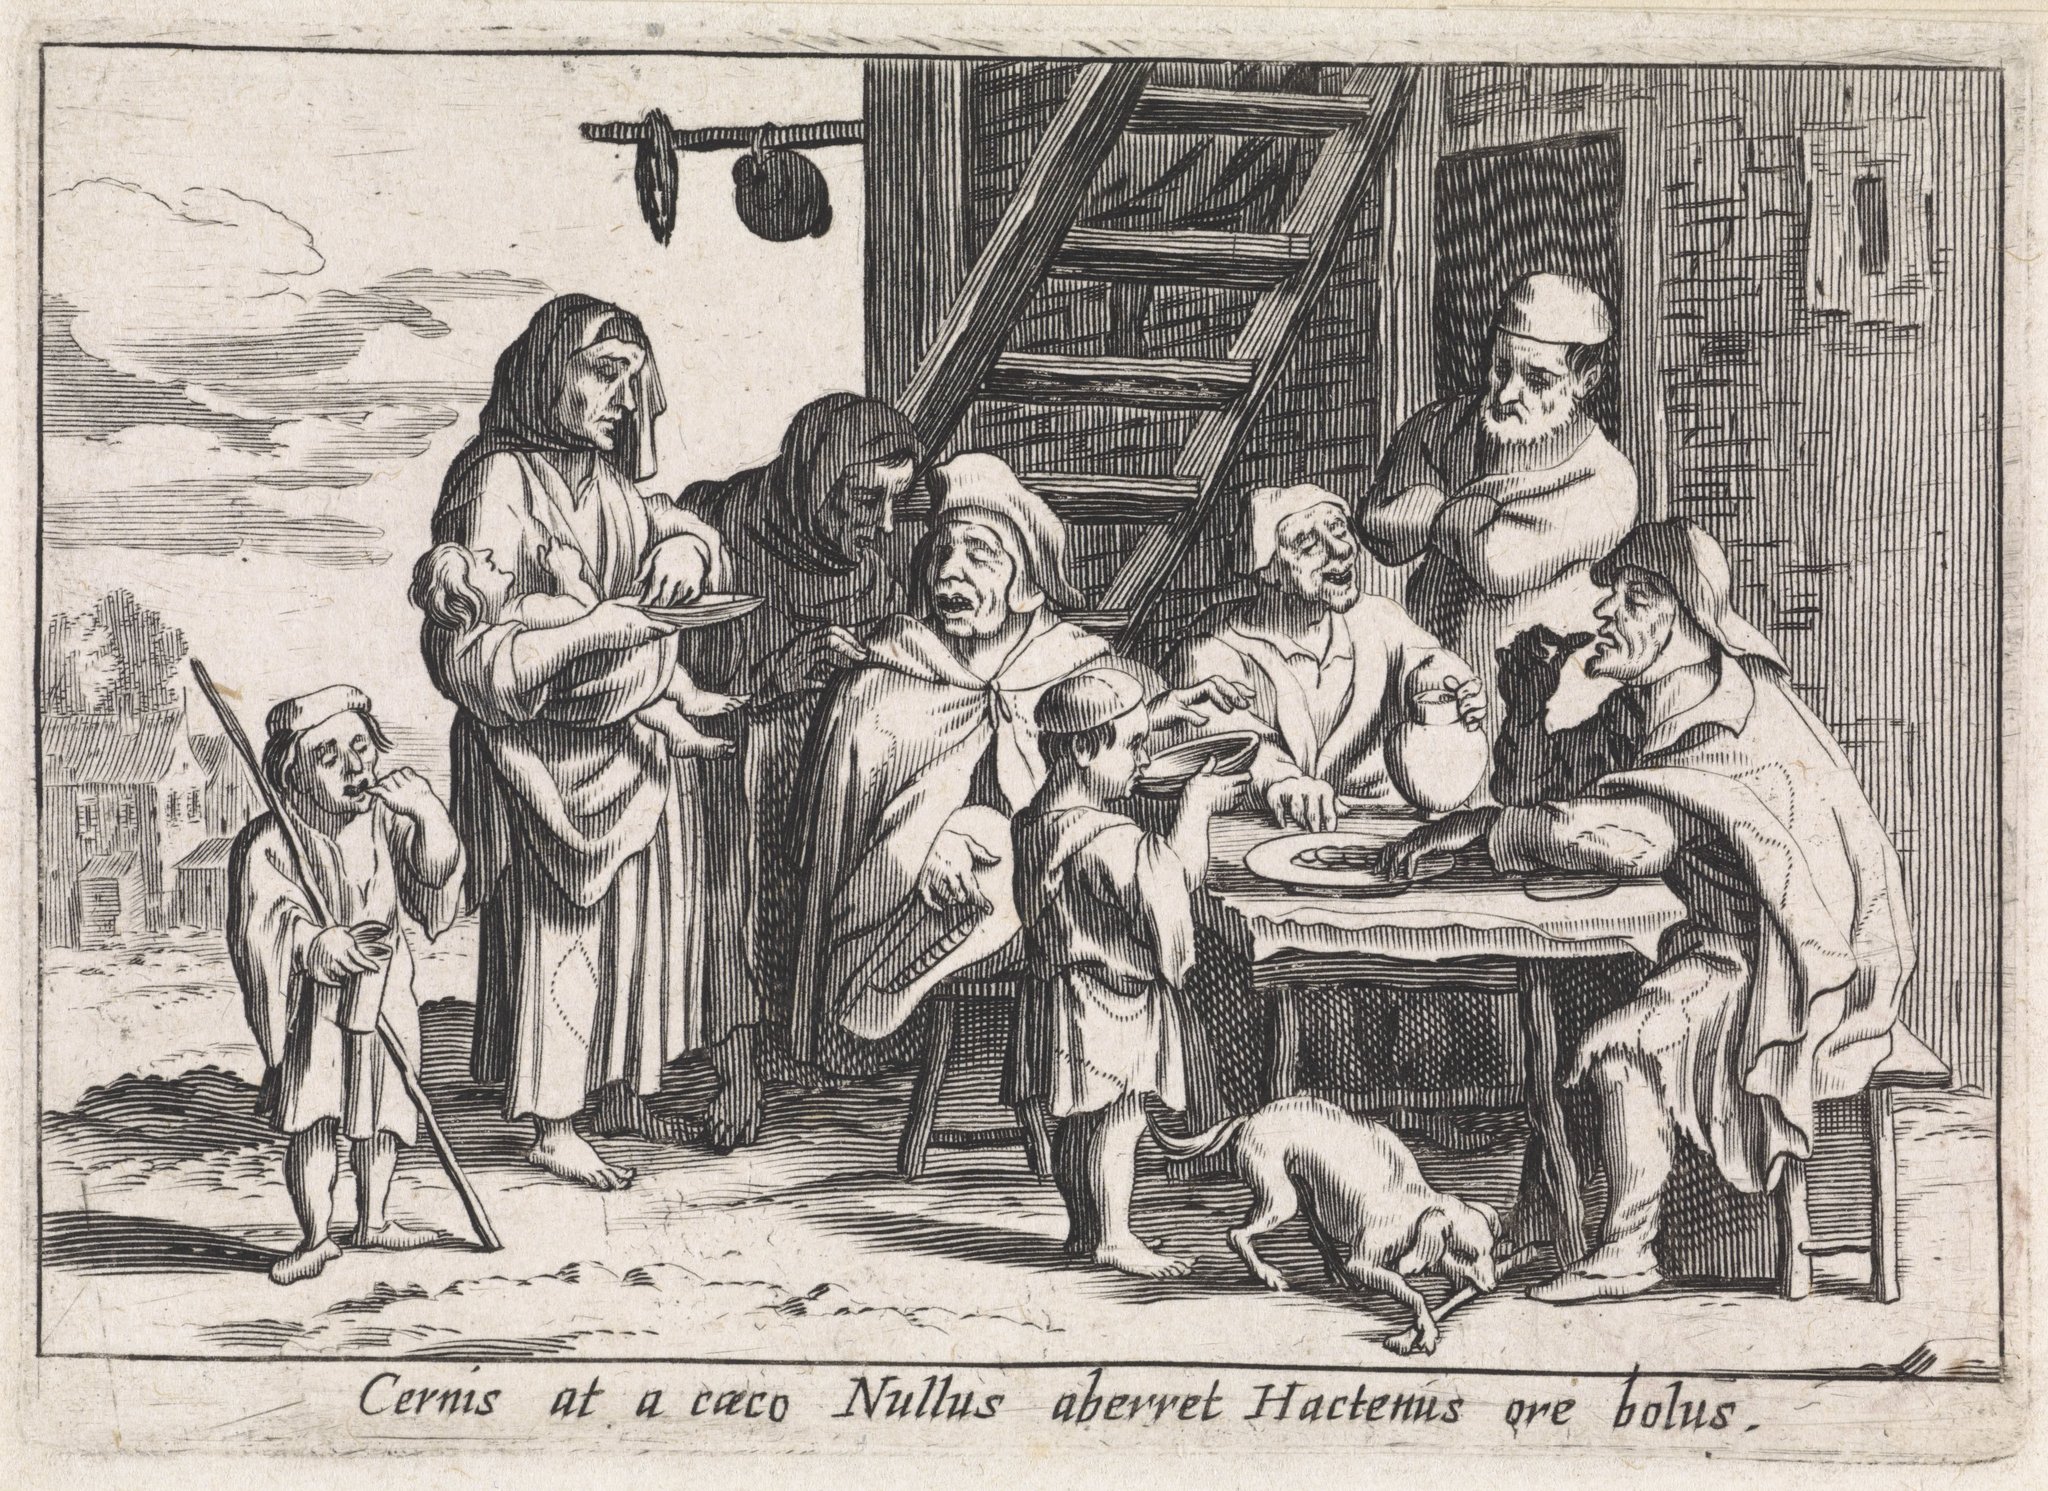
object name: print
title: Het betreurenswaardige lot van de blinden en de armen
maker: Anonymous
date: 1629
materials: paper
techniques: engraving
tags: giving alms or other charity, e.g.: handing out food, inn, coffee-house, public house, etc., blind, blindness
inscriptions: collector's mark: Lugt 240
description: Drie blinden eten aan een tafel voor een herberg. De waard en waardin kijken toe. Onder de tafel kluift een hond op zijn bot. Links een blind kind met een wandelstok. In de marge een onderschrift in het Latijn.